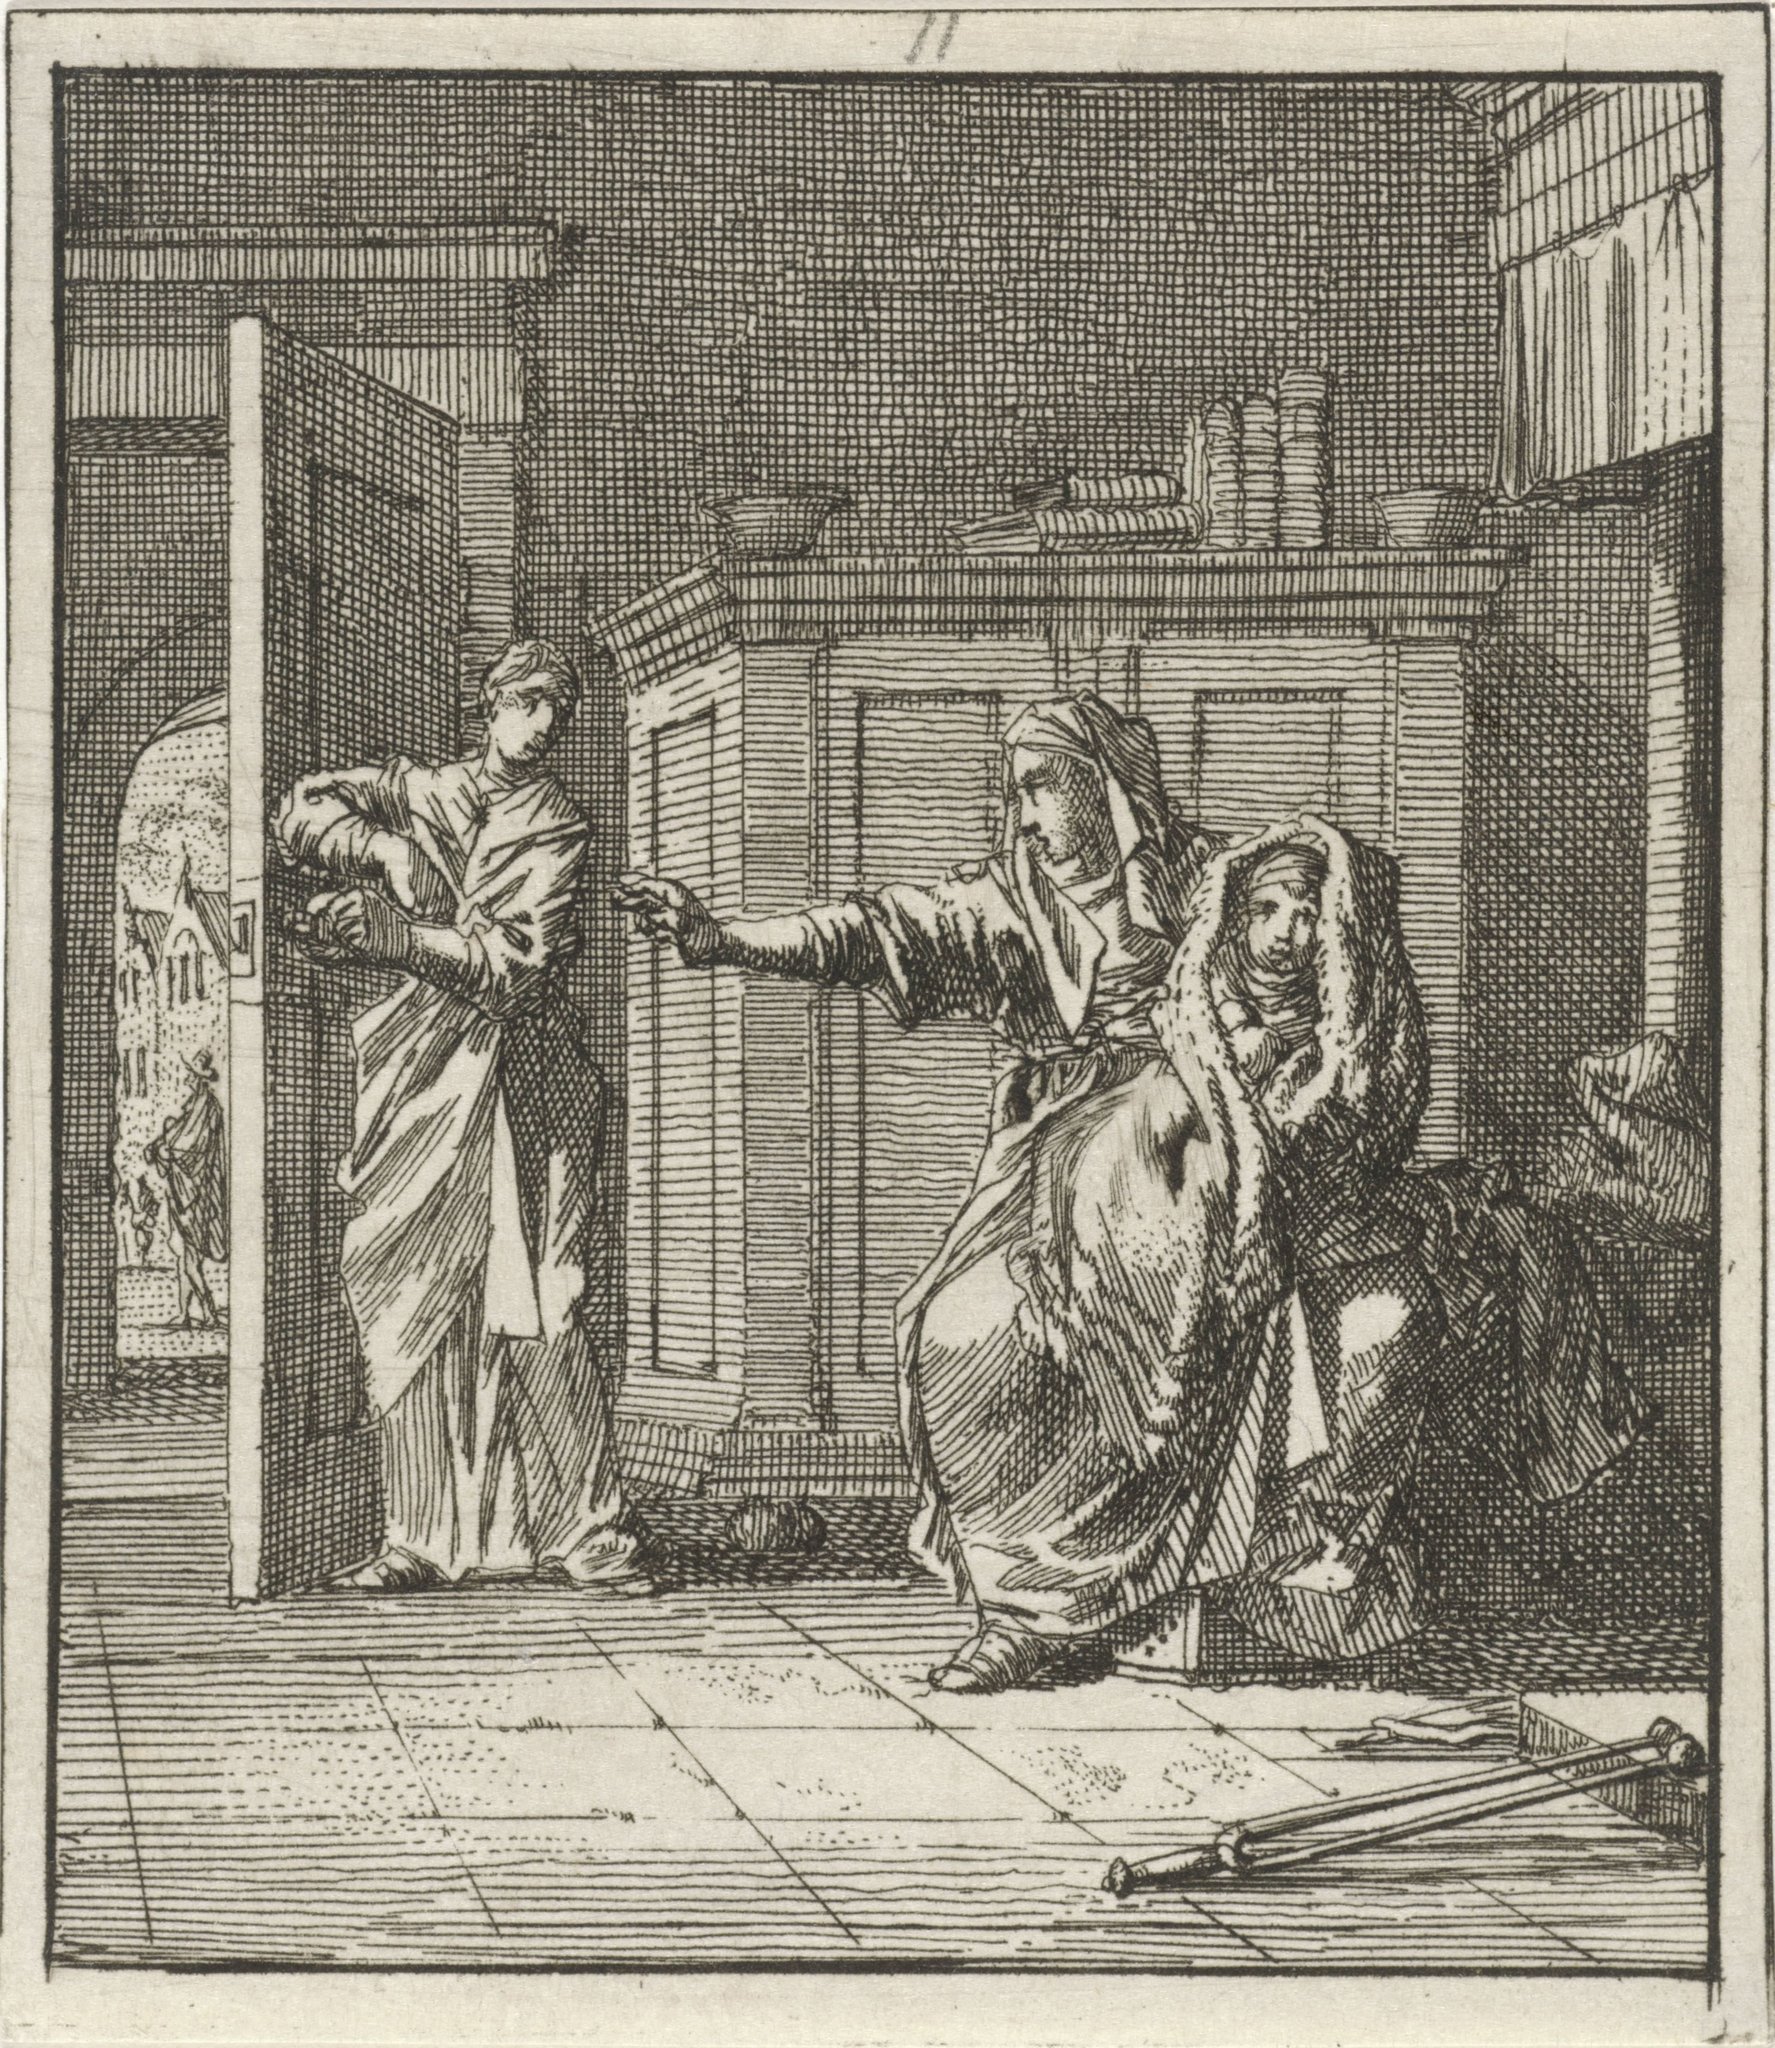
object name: print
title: Het Kindje Beschermd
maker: jan luyken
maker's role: draughtsman, print maker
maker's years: 1649-1712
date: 1712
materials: paper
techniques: etching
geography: amsterdam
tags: closing, shutting the door, mother and baby or young child, house personnel, servants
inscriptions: number: ‘11’, collector's mark: Lugt 2228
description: Proefdruk van illustratie uit: Luyken, Jan. Des menschen begin, midden en einde. Amsterdam: Wed. Pieter Arentsz II en Cornelis van der Sys, 1712, p. 23.